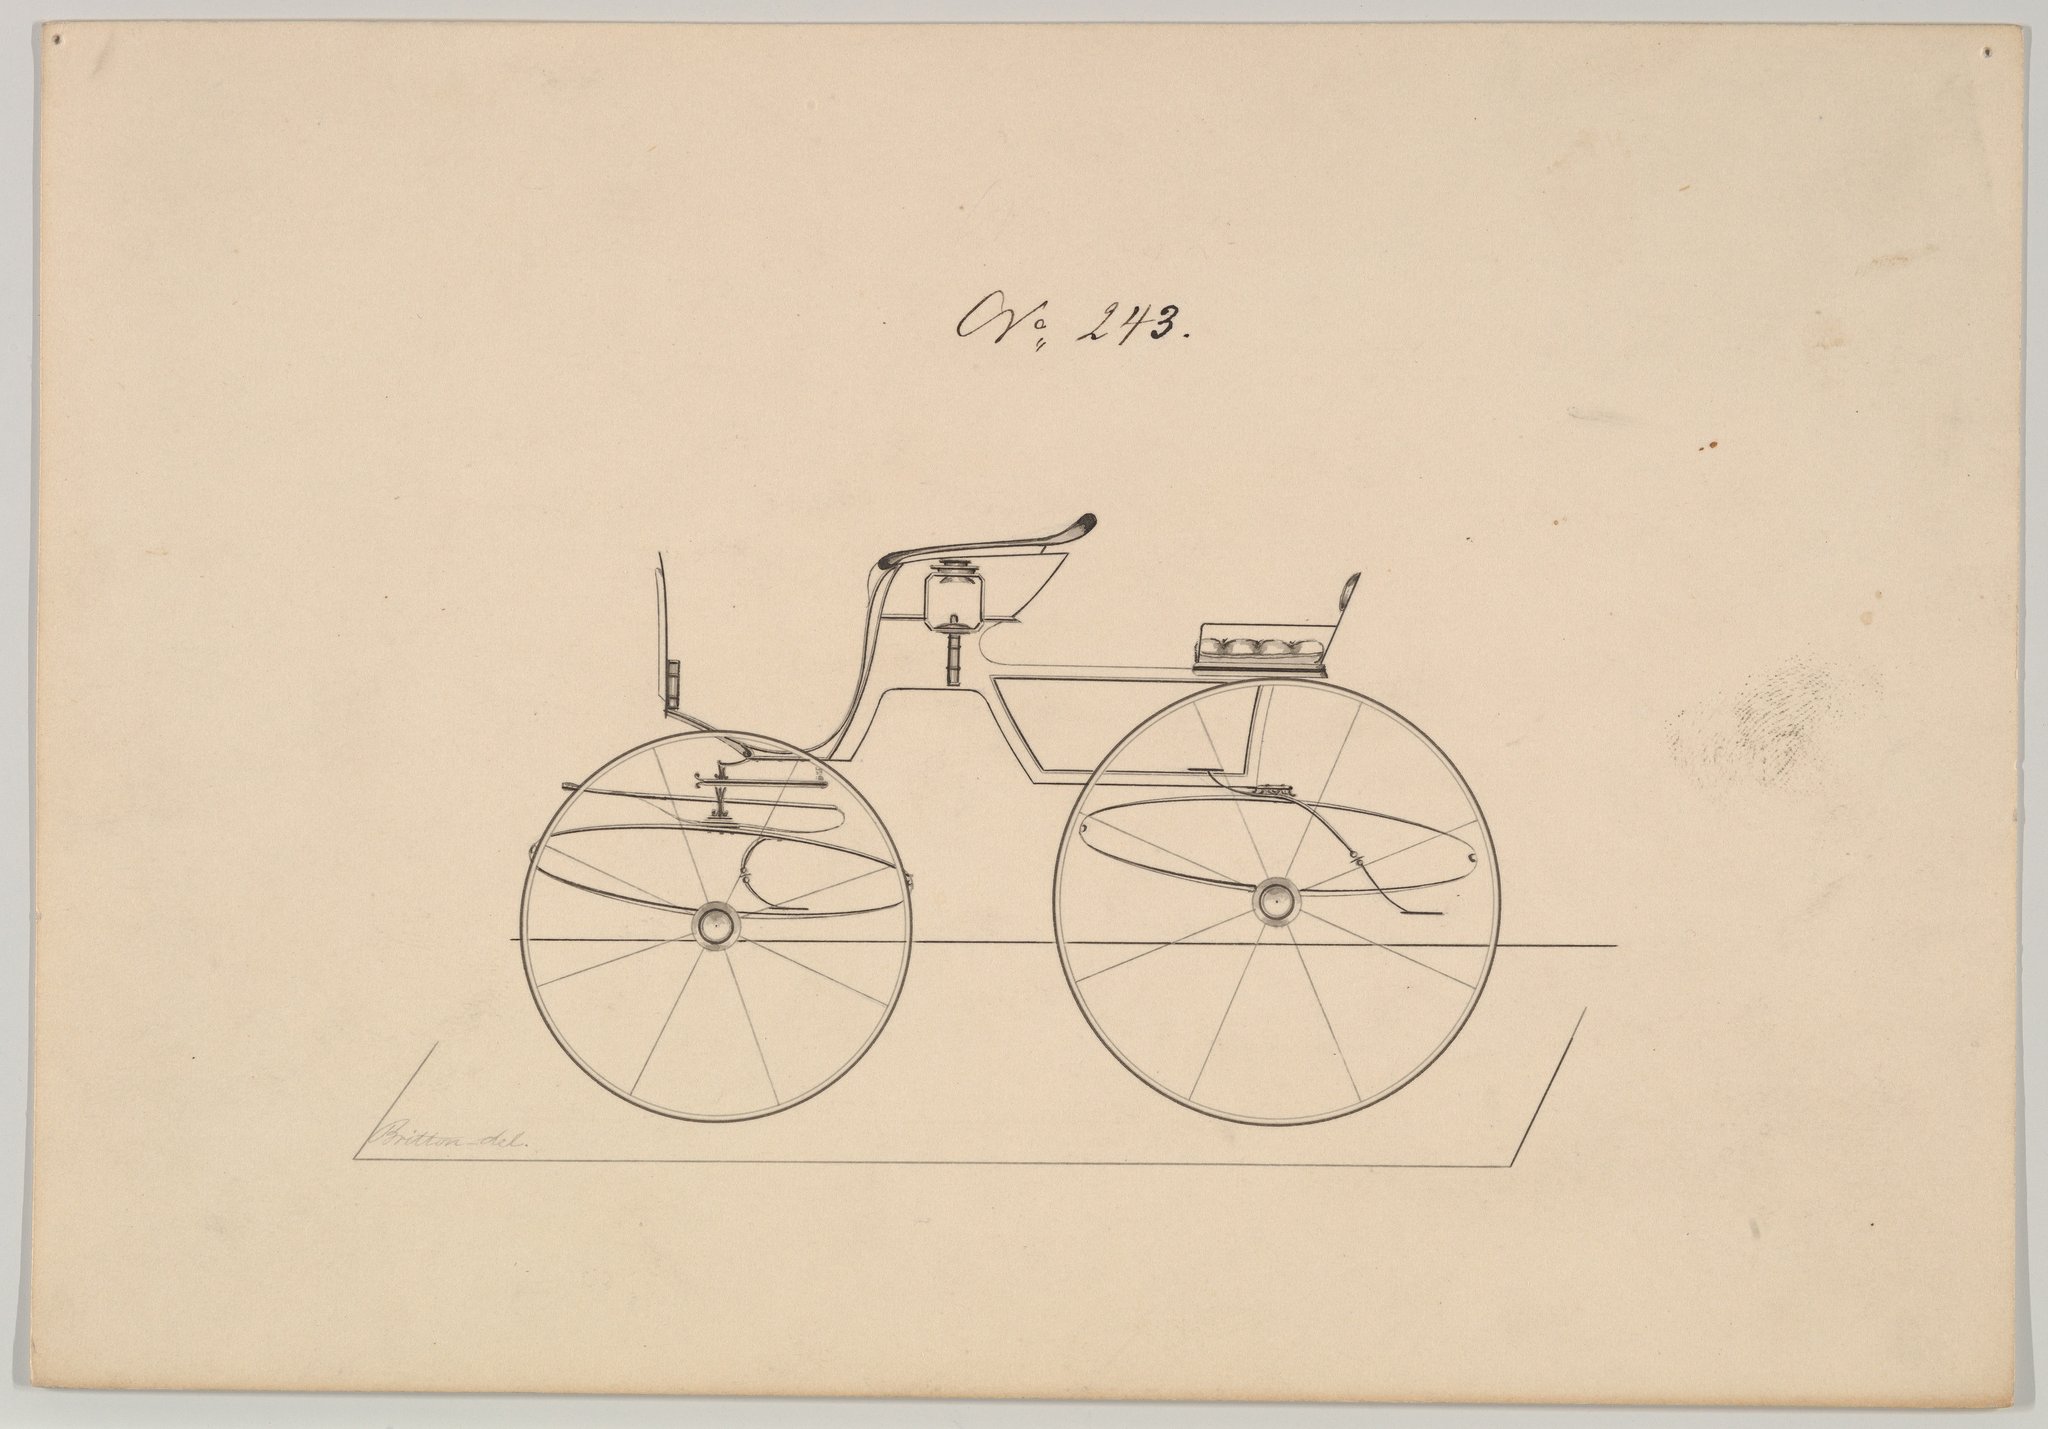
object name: drawing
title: Dog Cart Phaeton # 243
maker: brewster & co.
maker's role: manufacturer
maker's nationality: american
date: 1850-1870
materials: ink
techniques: pen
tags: carriages